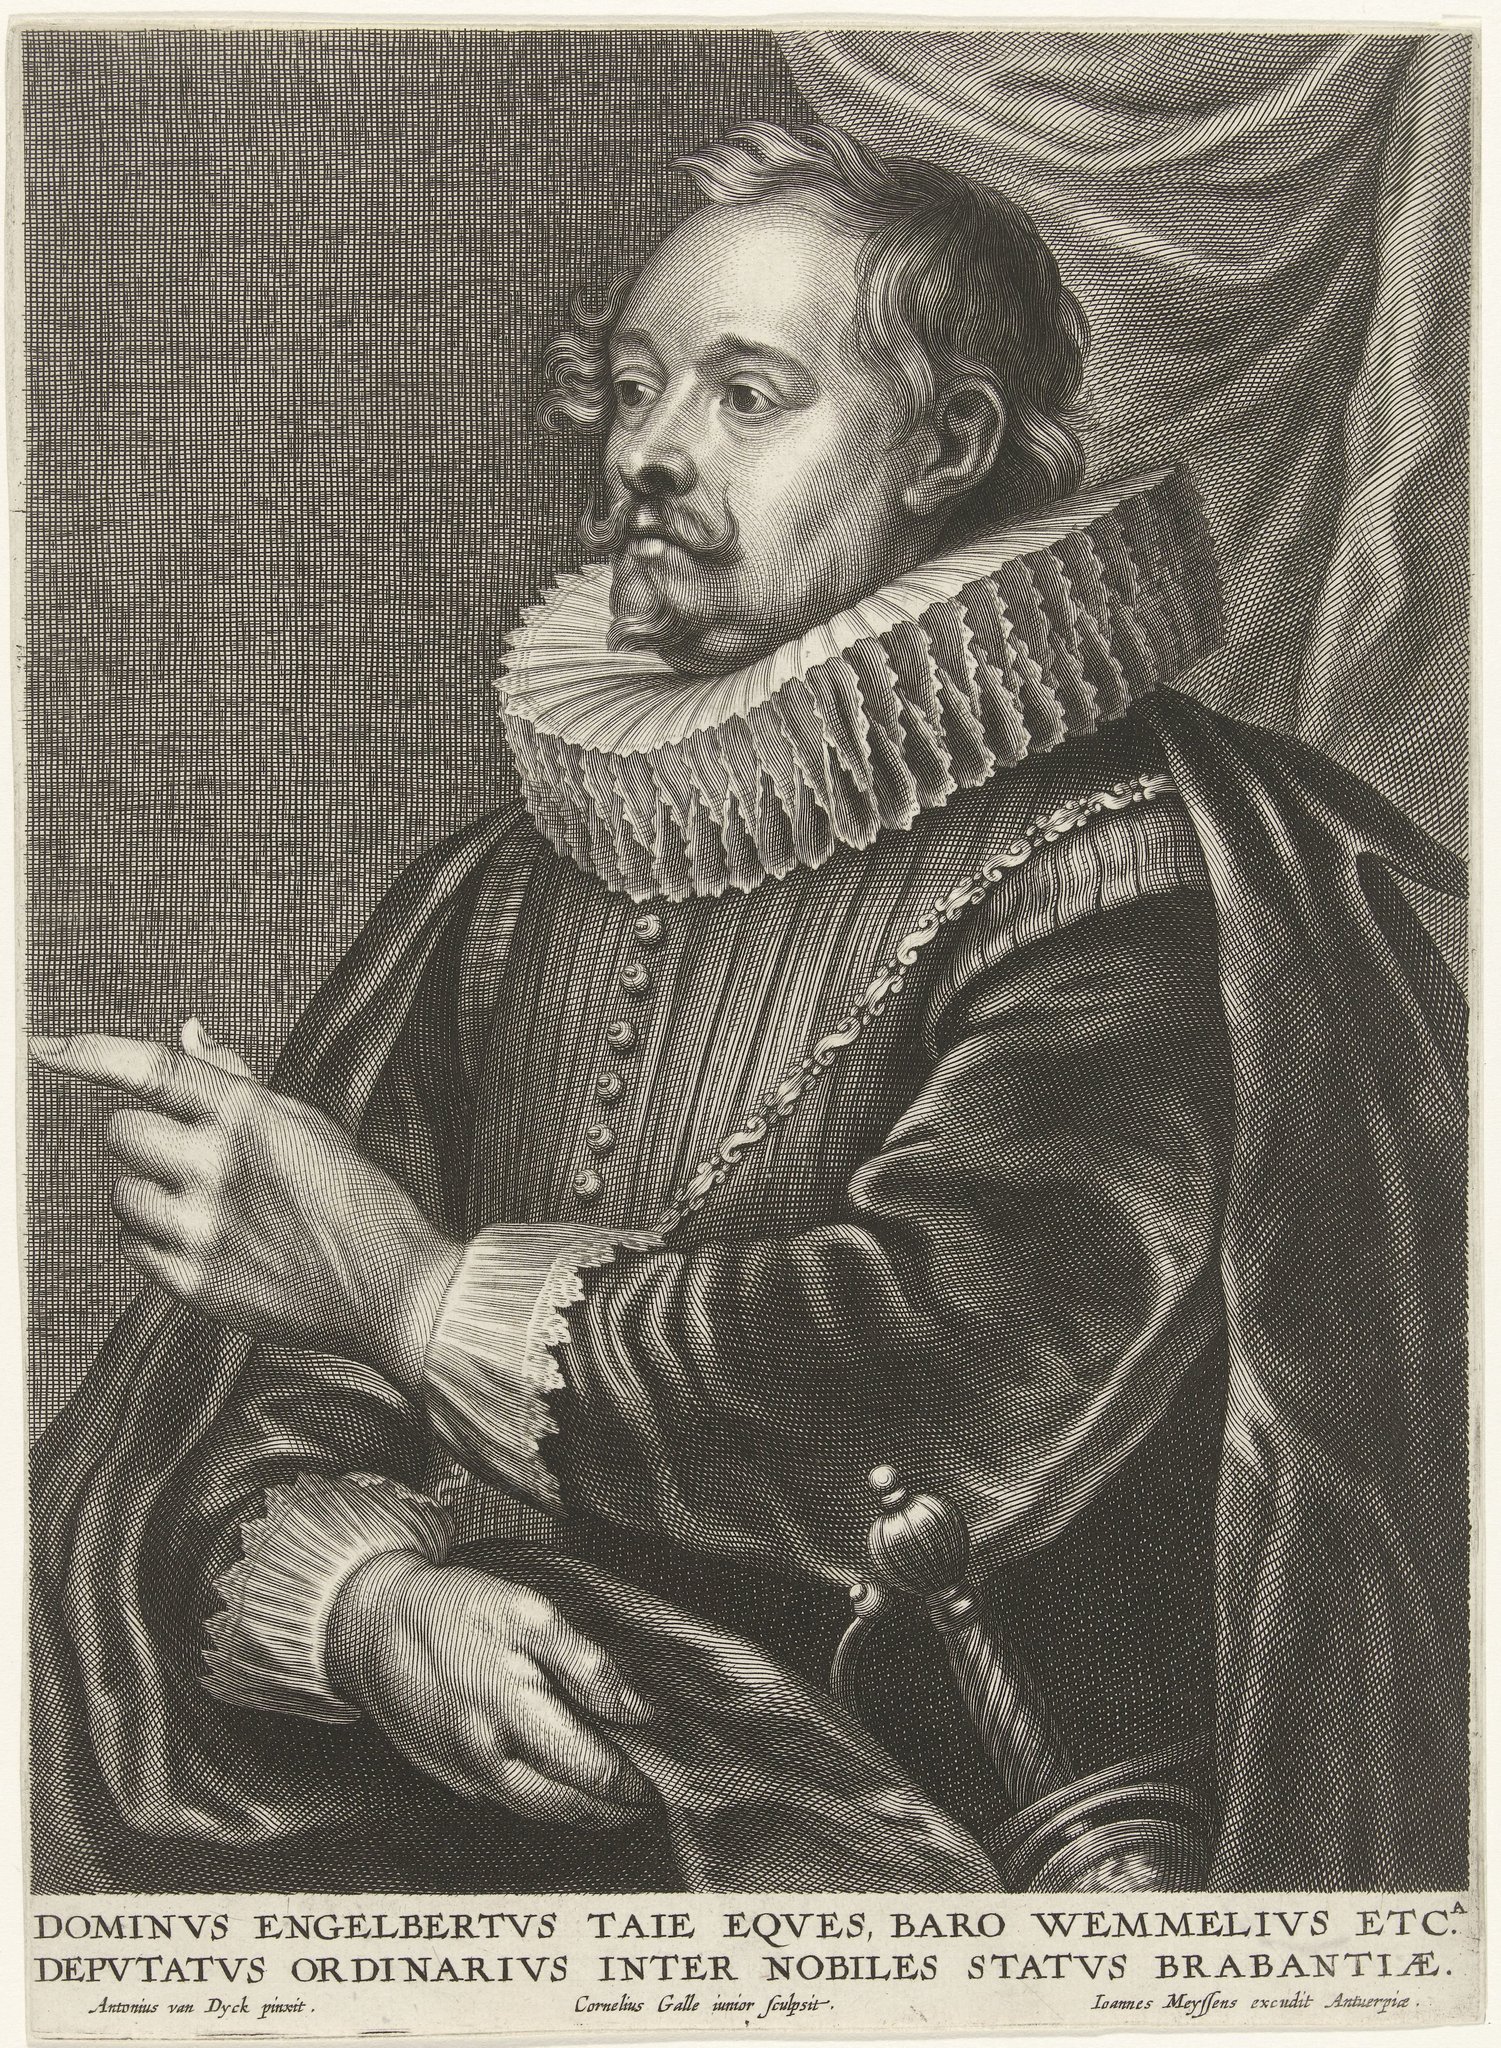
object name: print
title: Portret van Engelbert Tajé, baron van Wemmel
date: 1638-1670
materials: paper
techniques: engraving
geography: antwerp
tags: engelbert taye (baron van wemmel)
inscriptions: collector's mark: Lugt 240